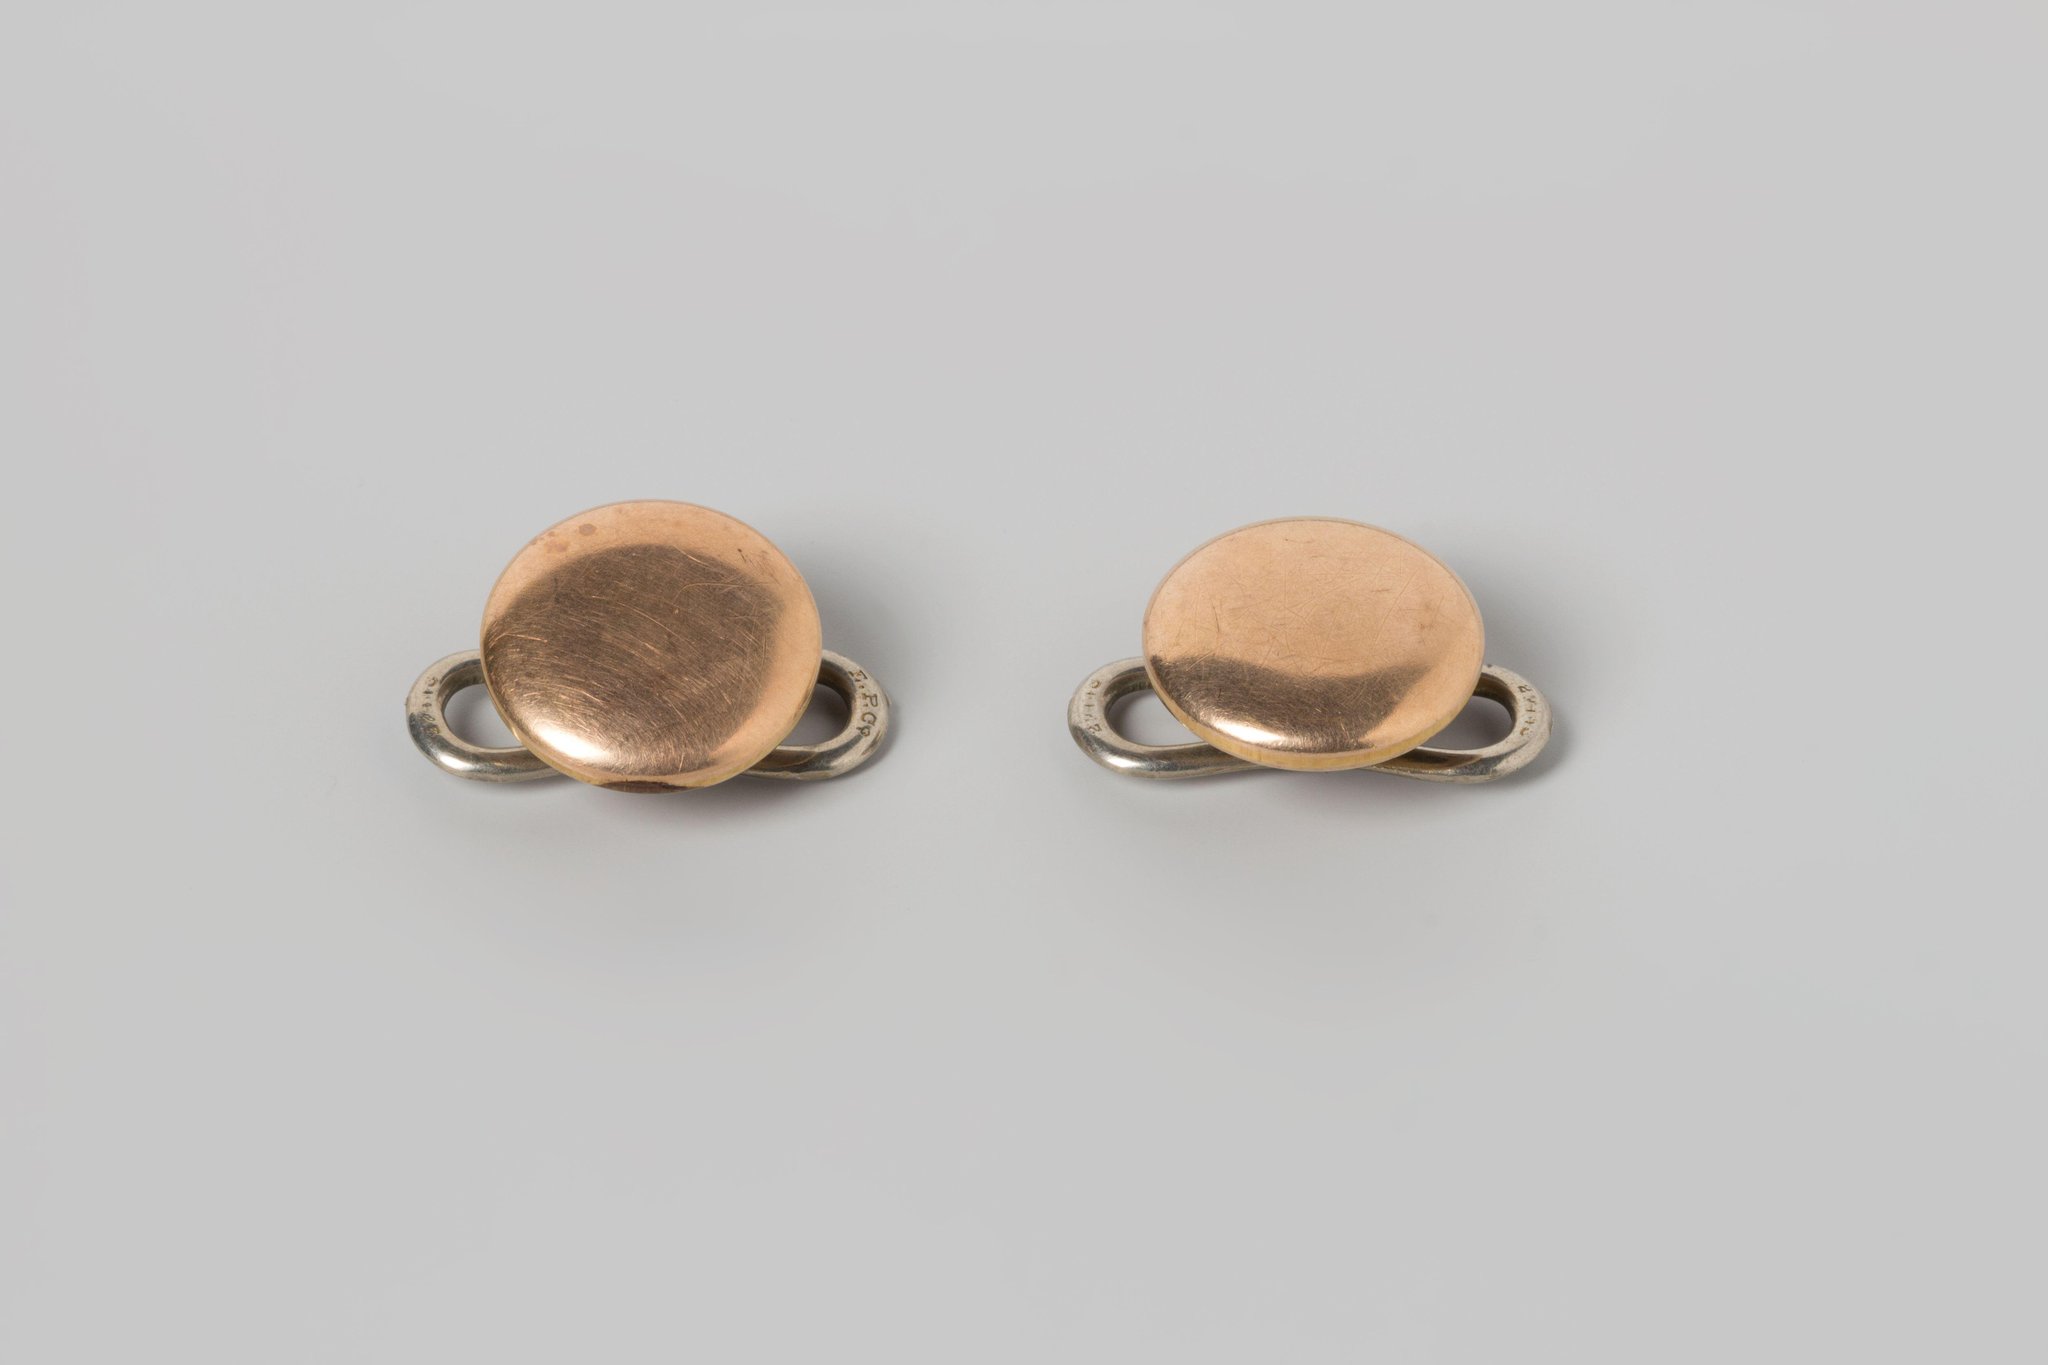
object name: menswear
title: Vestknoop van metaal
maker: Anonymous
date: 1900-1940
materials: metal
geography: netherlands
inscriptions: mark: ‘F.P.Co’